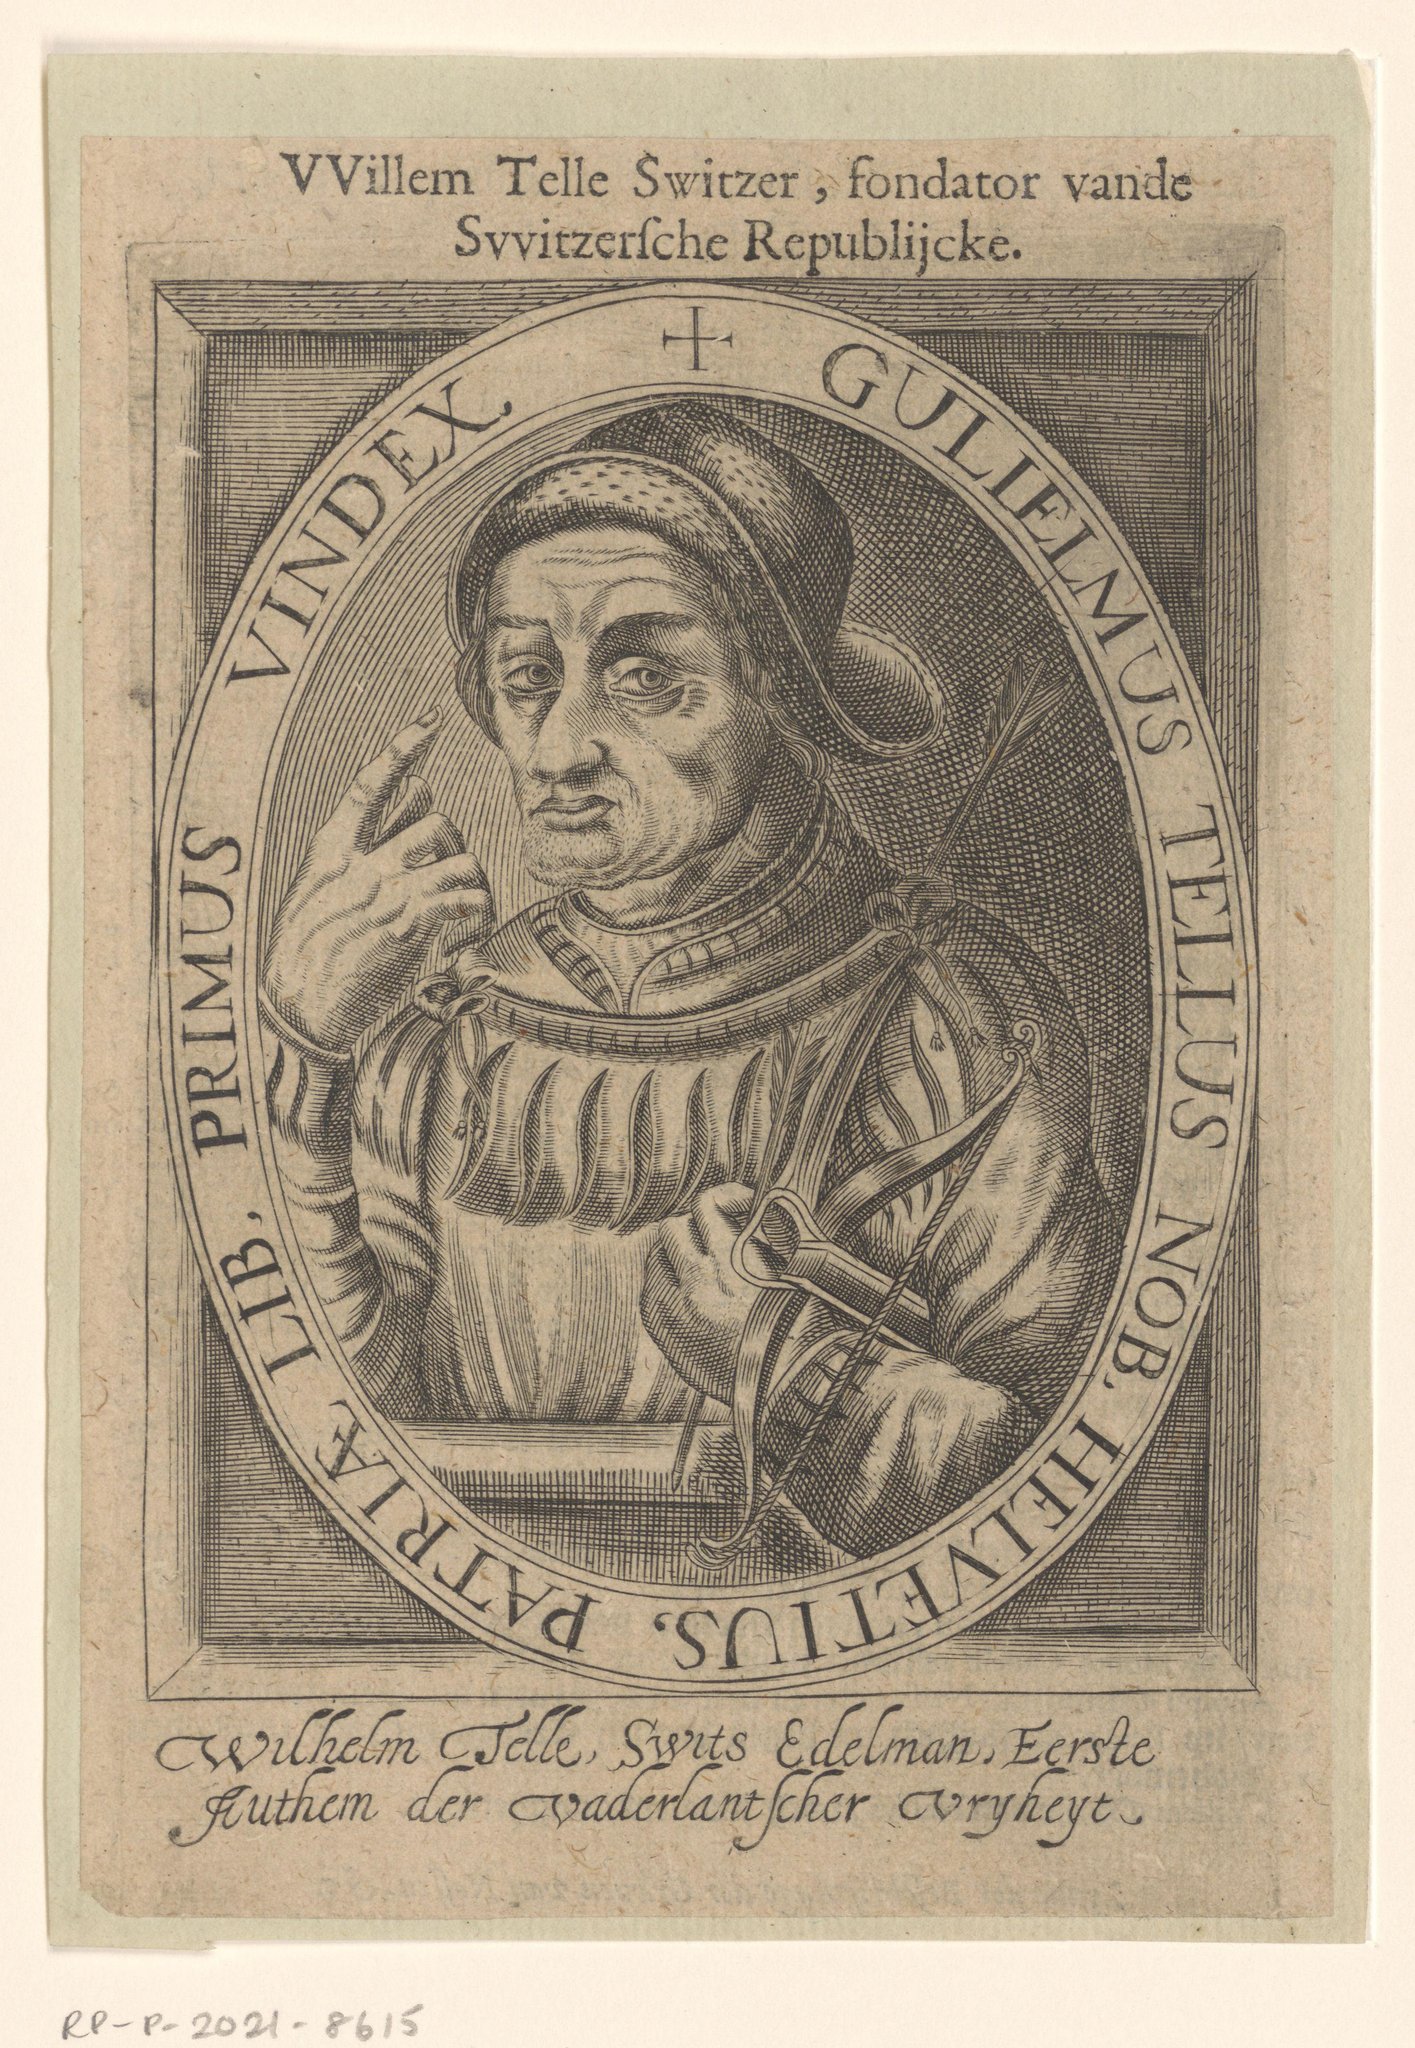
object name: print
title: Portret van William Tell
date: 1617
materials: paper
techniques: engraving, letterpress printing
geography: delft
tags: historical persons, archer's weapons: crossbow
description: Prent uit: Clerck, Nicolaes de. Tooneel der beroemder hertogen, princen, graven ende krygs-helden (...). Delft: Nicolaes de Clerck, 1617, p. 302.